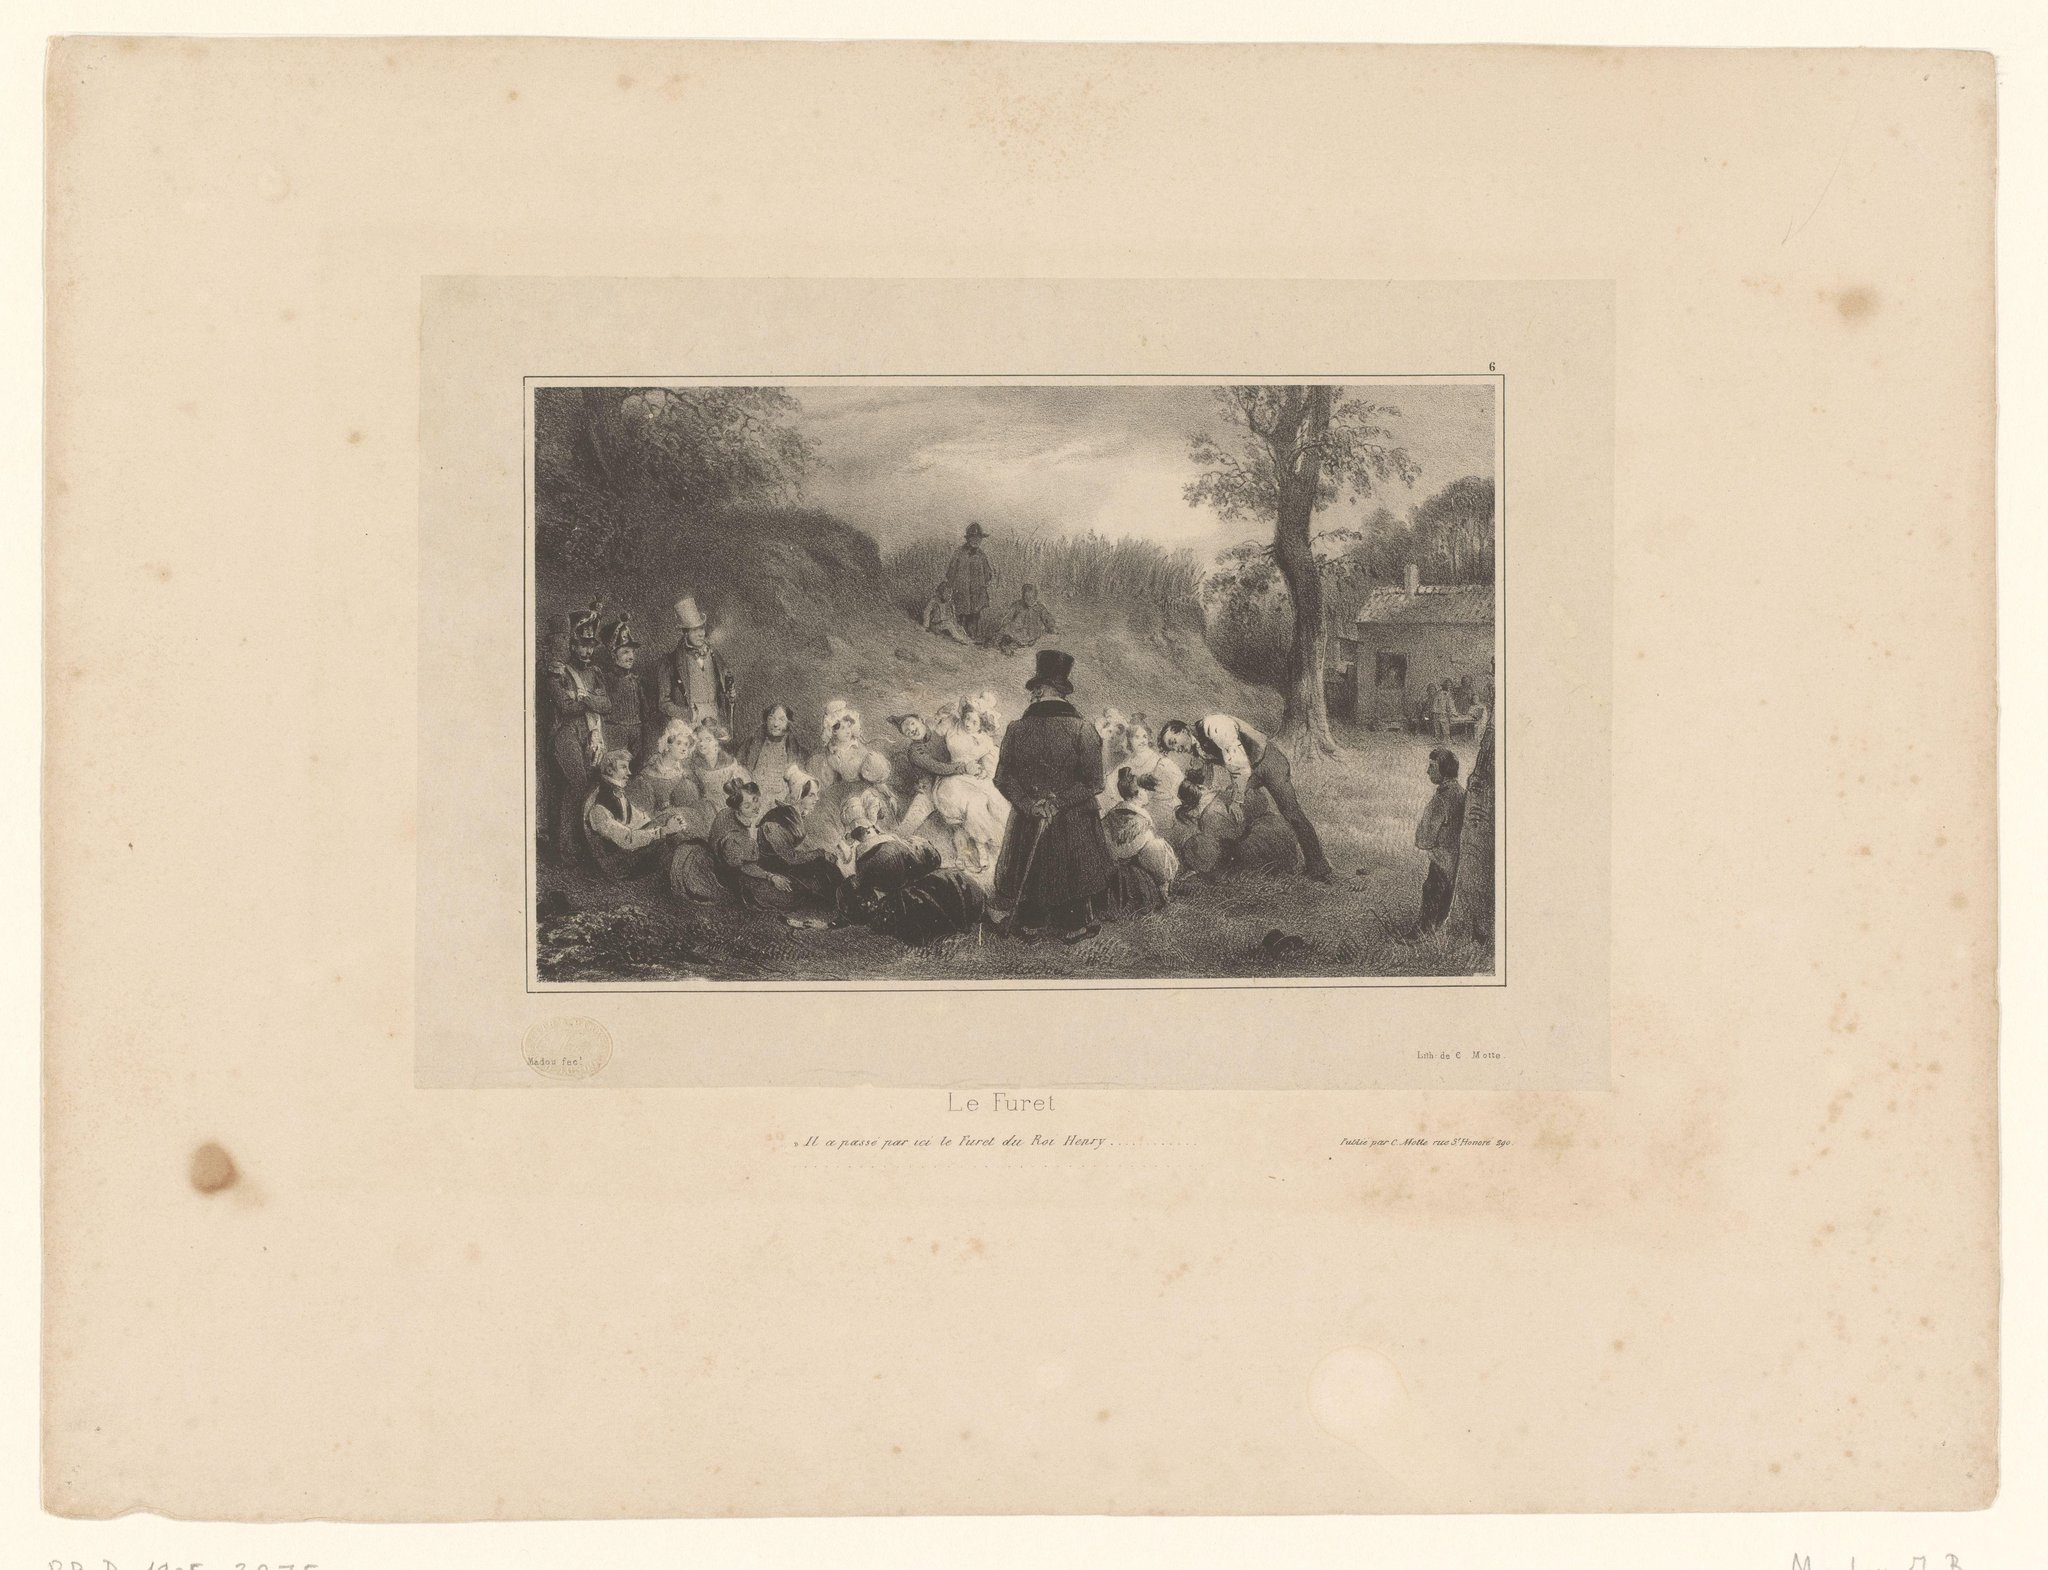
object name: print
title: Twaalf genretaferelen met vermakelijkheden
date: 1833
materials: paper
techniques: lithograph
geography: paris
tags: games without play material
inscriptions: check stamp: Lugt 1828b, collector's mark: Lugt 2228